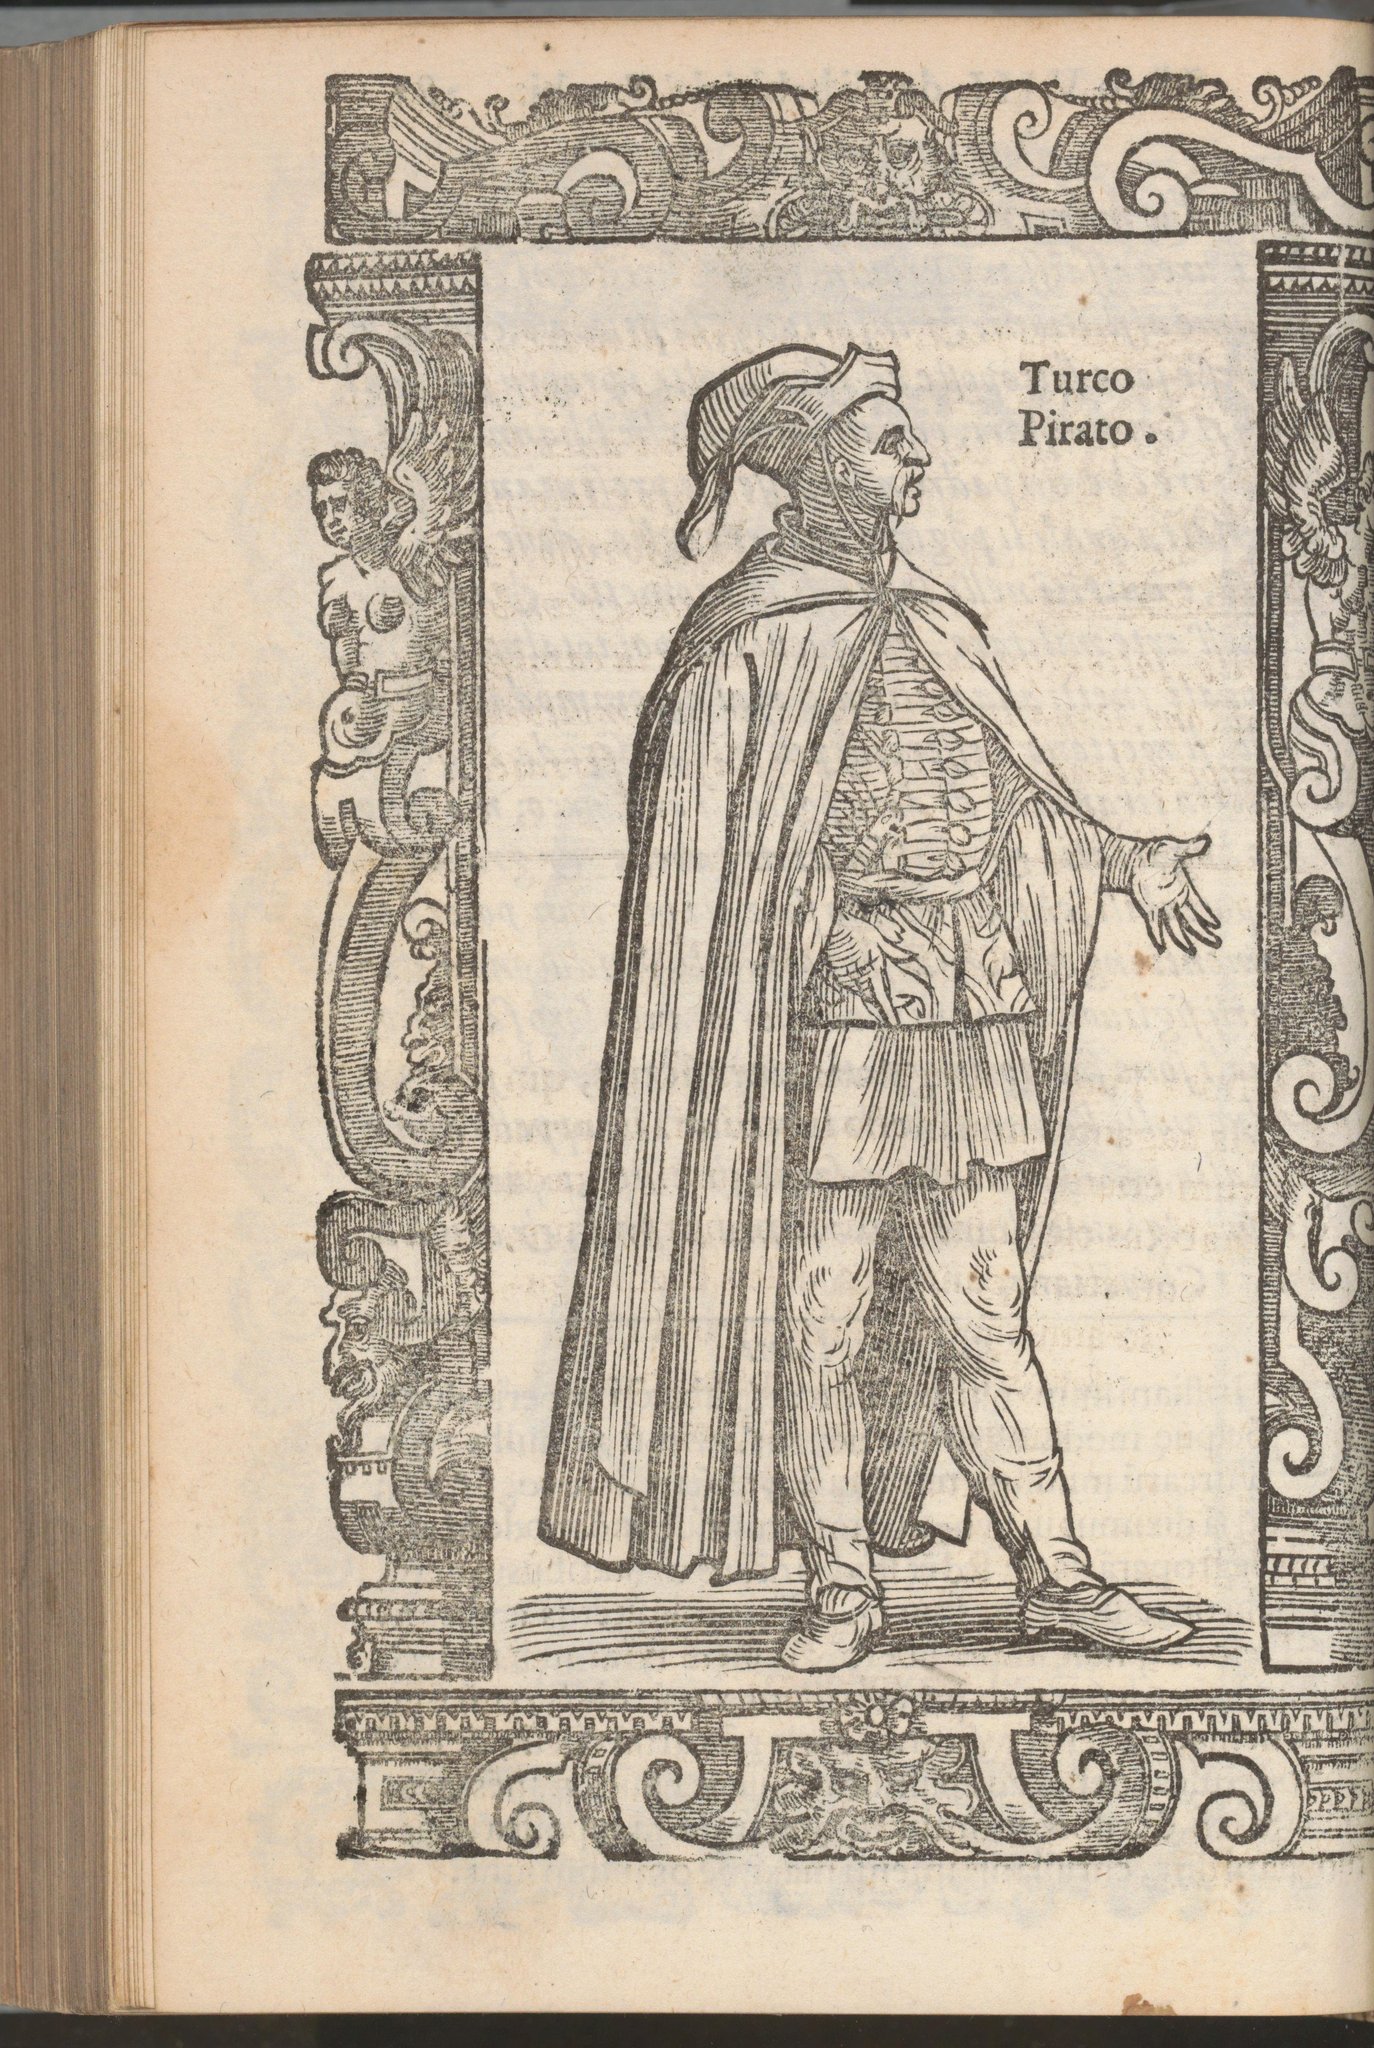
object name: costume print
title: Habiti antichi, et moderni di tutto il mondo...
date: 1598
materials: paper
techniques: woodcut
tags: pirate, corsair, buccaneer, asiatic races and peoples: turks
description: Turkse piraat, gekleed in een lange schoudermantel waaronder een wambuis en broek. Muts met punt op het hoofd.